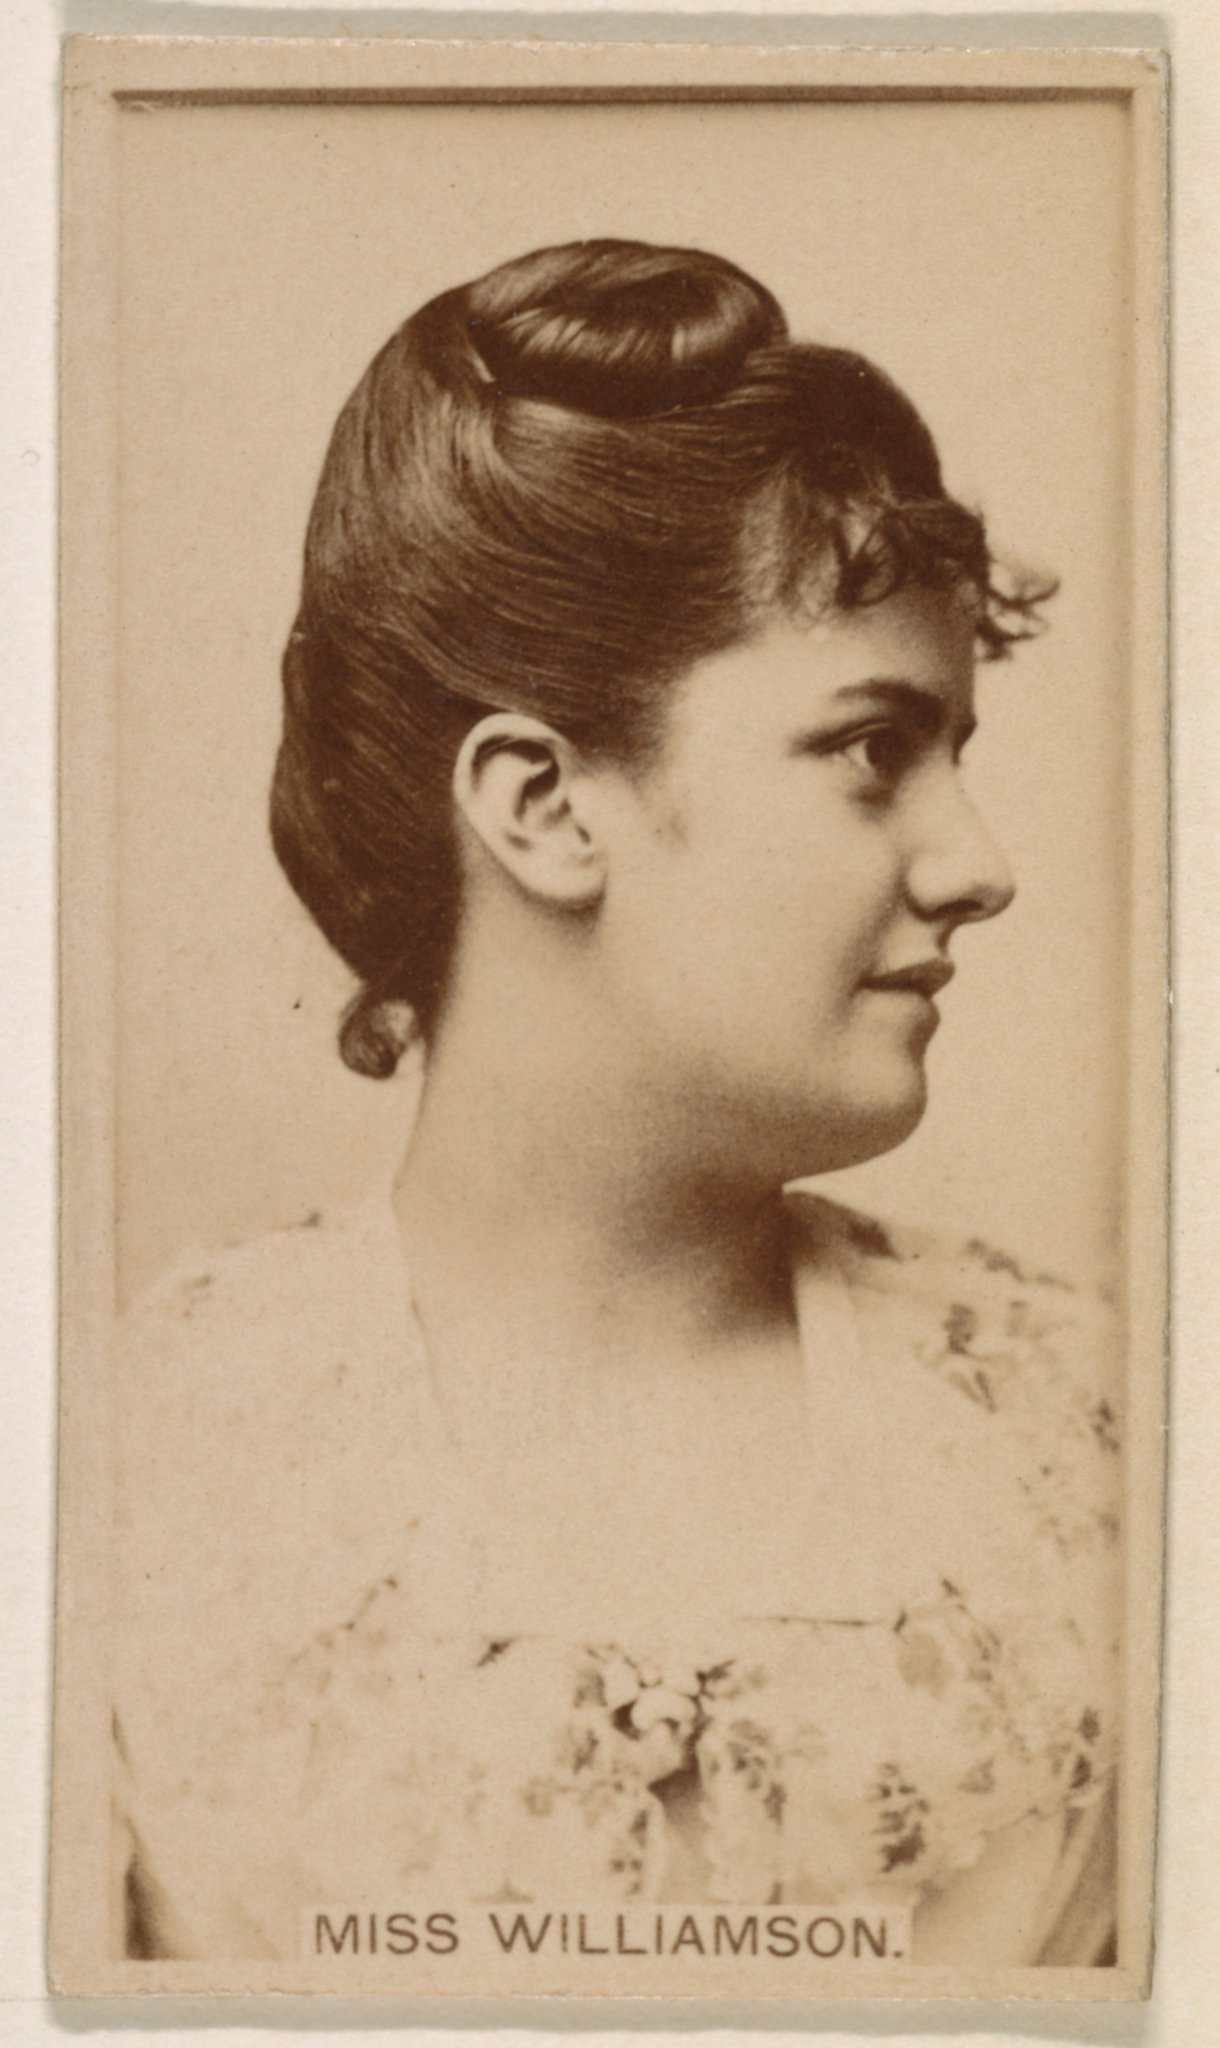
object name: photograph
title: Miss Williamson, from the Actresses series (N245) issued by Kinney Brothers to promote Sweet Caporal Cigarettes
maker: kinney brothers tobacco company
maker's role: publisher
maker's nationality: american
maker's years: 1869-2011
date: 1890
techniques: albumen silver print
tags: women,actresses